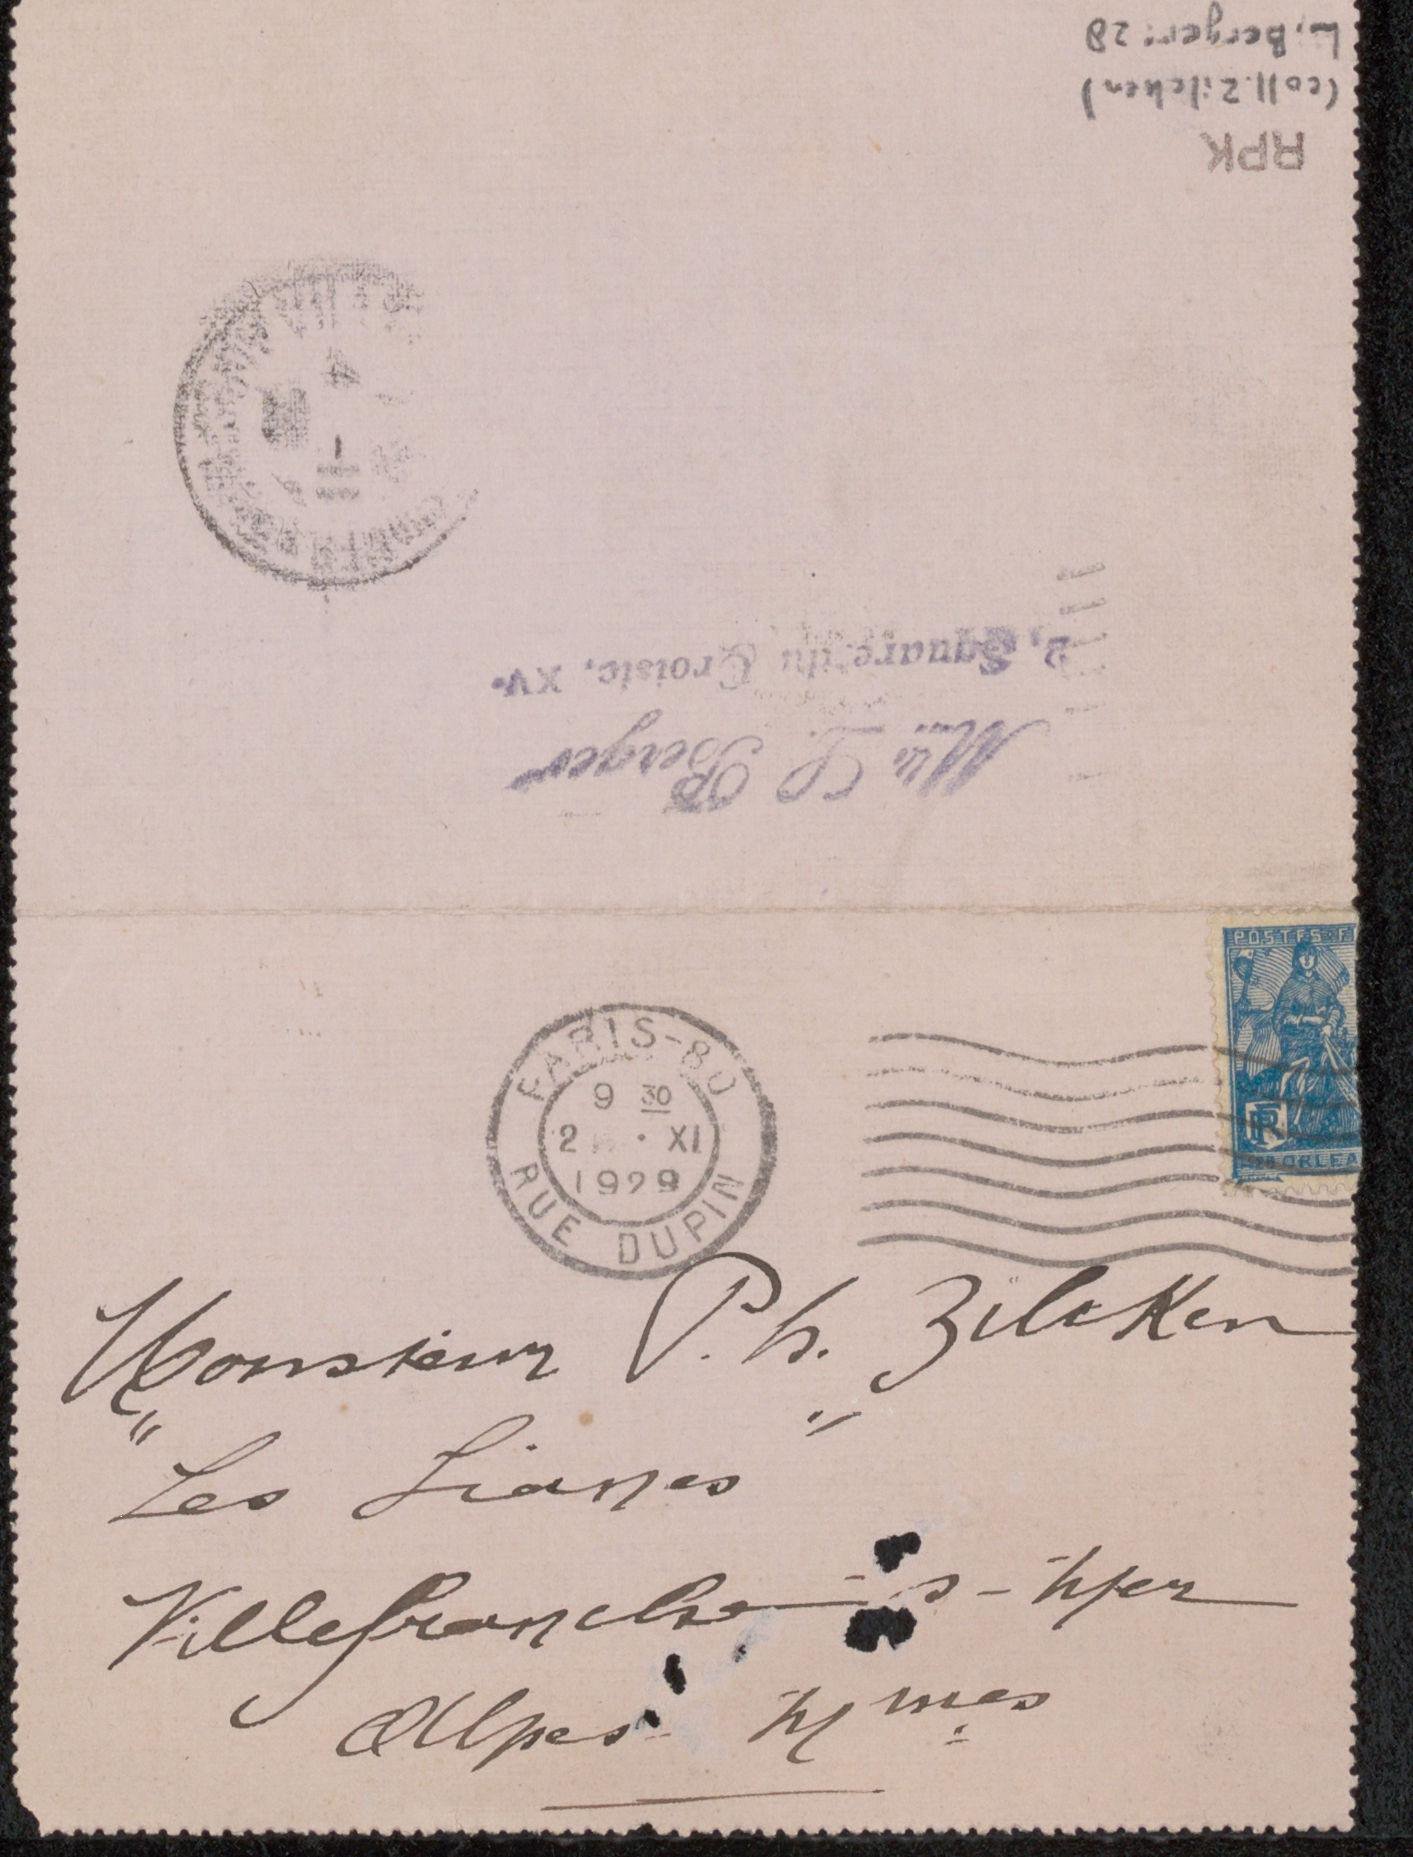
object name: letter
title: Brief aan Philip Zilcken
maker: lya berger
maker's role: schrijver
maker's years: 1877-1941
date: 1929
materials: ink, paper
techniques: pen, writing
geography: paris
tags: the hague, painter, draughtsman, philip zilcken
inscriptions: collector's mark: ‘RPK’, address: ‘Mlle. L. Berger/ 2, Square du Croisic, XVe’